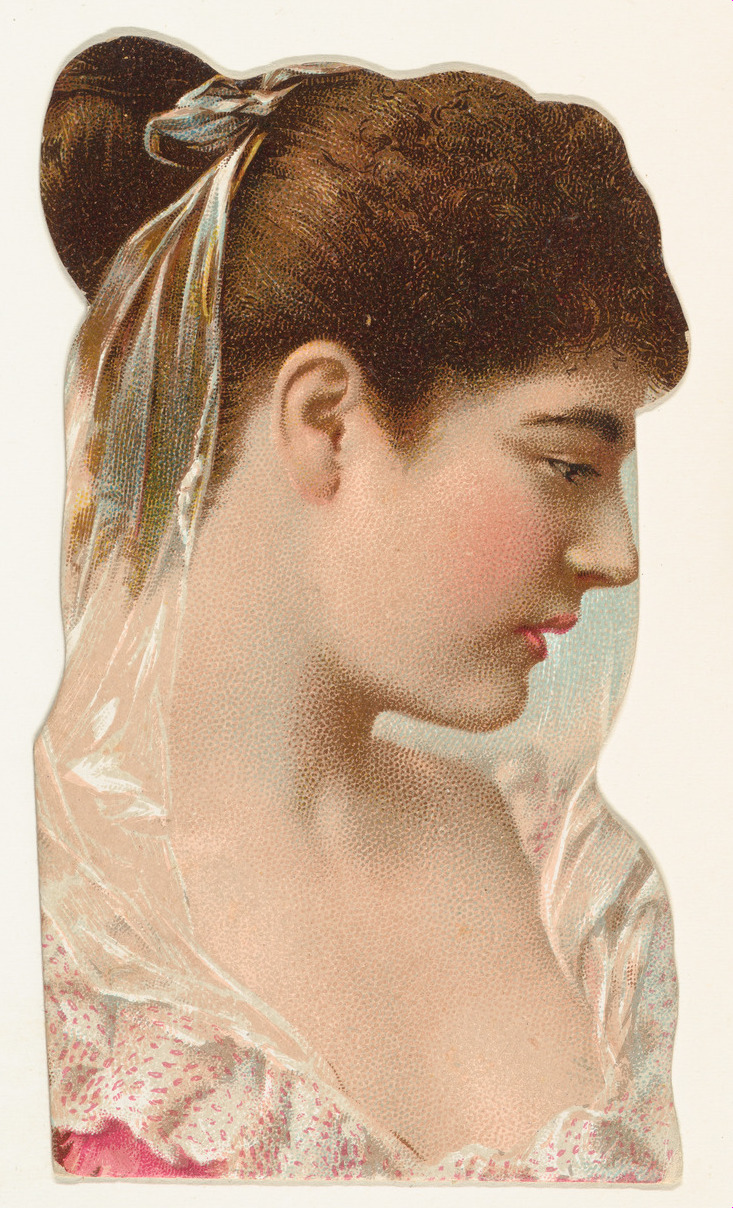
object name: print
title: Actress in profile, from Stars of the Stage, Fourth Series (N132) issued by Duke Sons & Co. to promote Honest Long Cut Tobacco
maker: w. duke, sons & co.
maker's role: publisher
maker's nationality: american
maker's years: 1870-1920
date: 1892-1893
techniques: color lithograph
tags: women,actresses